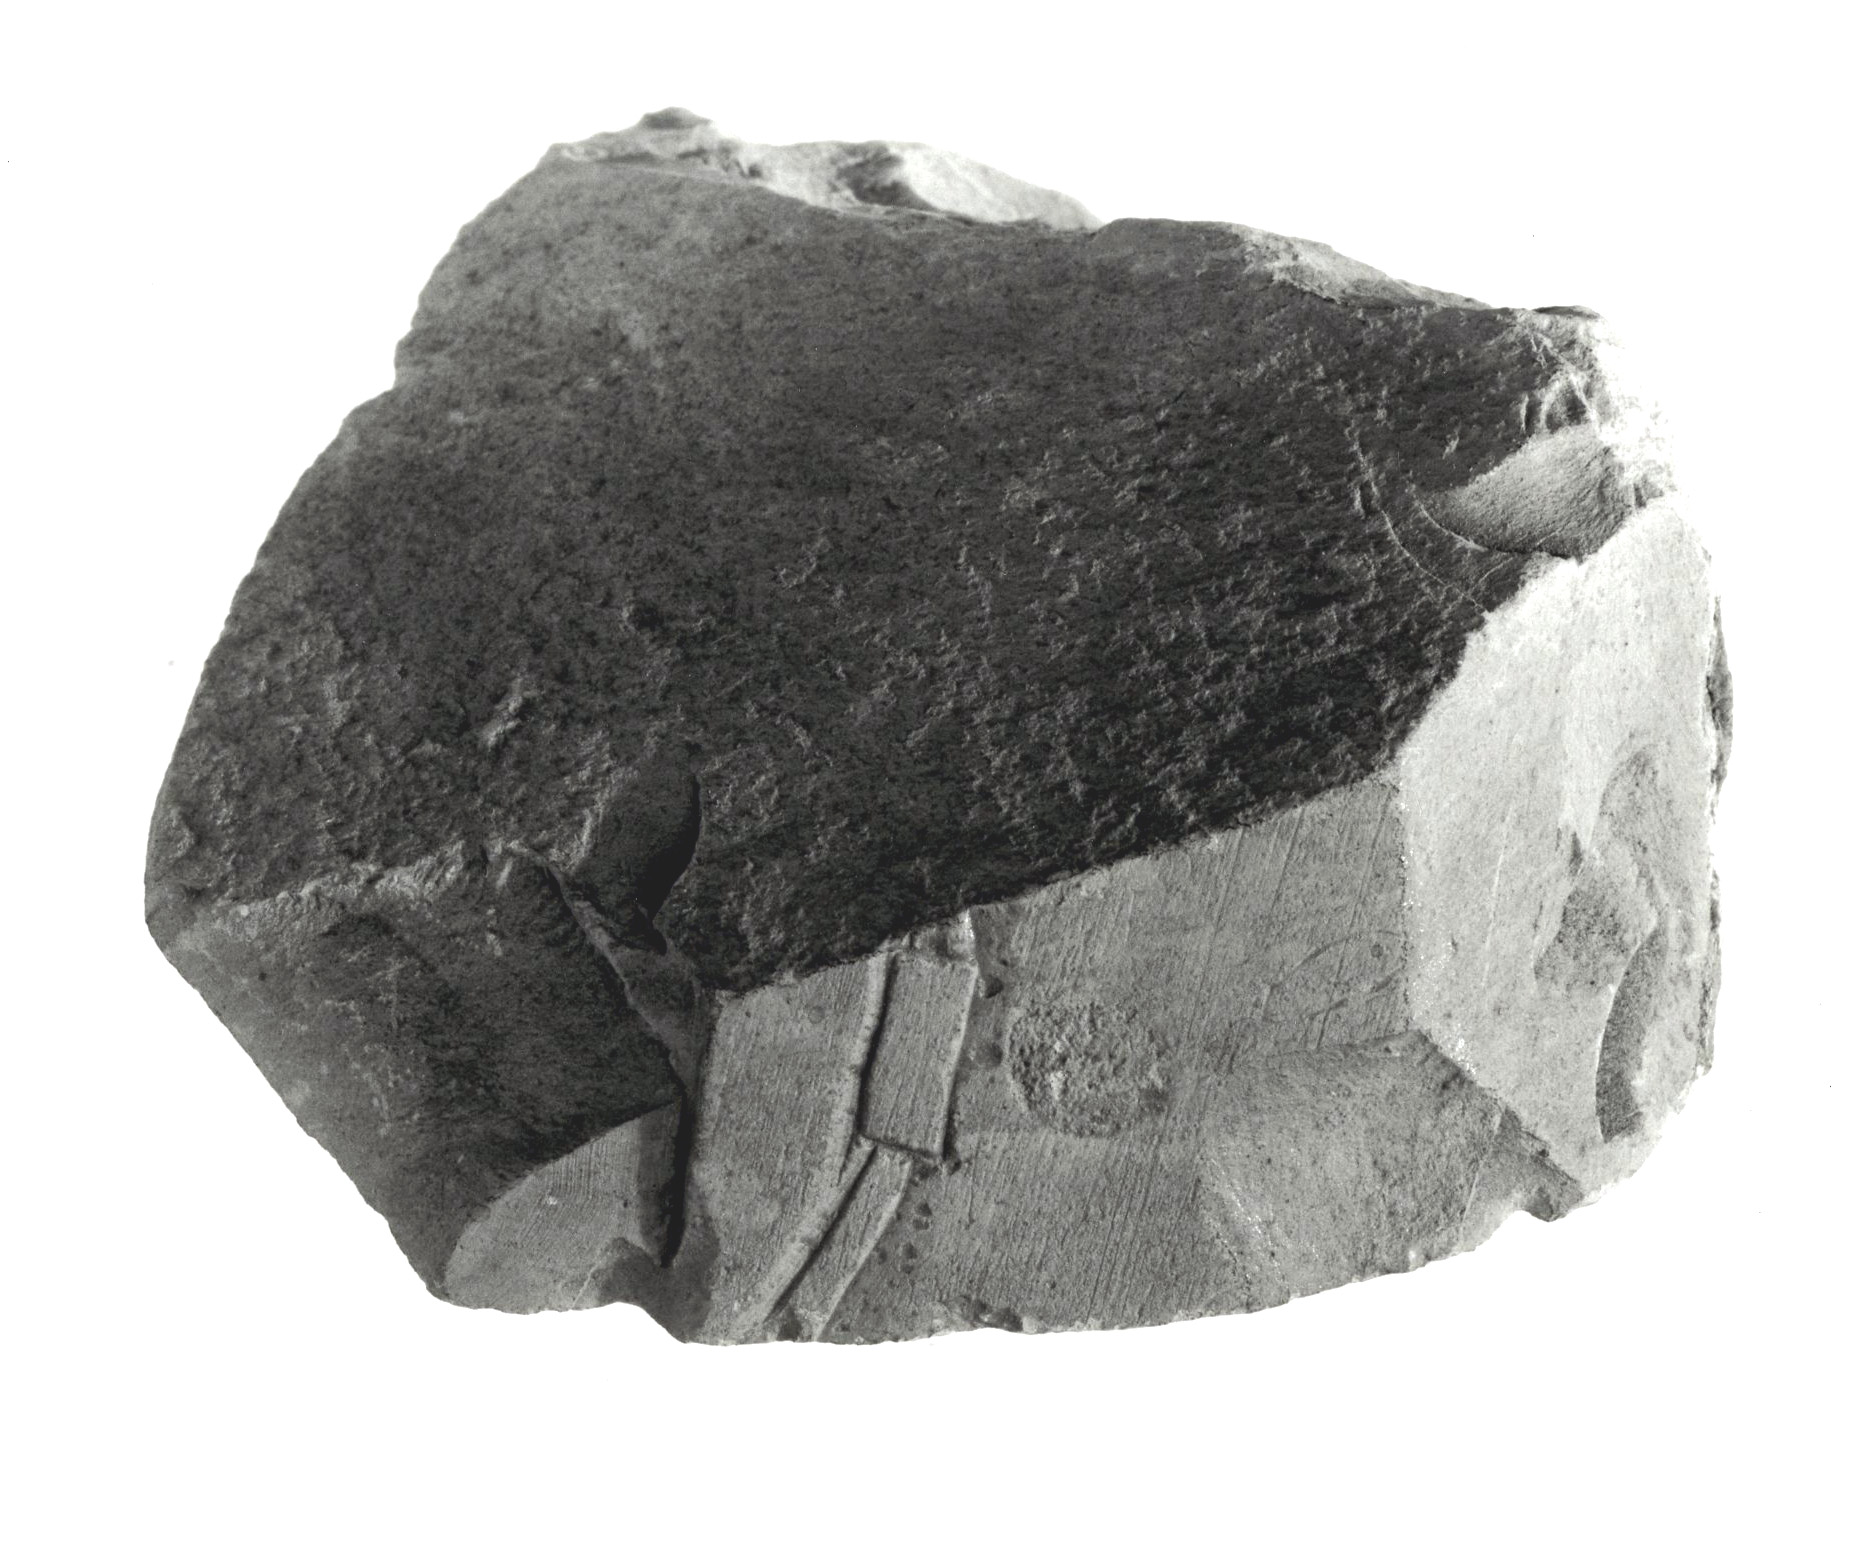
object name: relief, tomb of nespekashuty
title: Raised relief fragment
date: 664-610 BCE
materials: limestone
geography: egypt